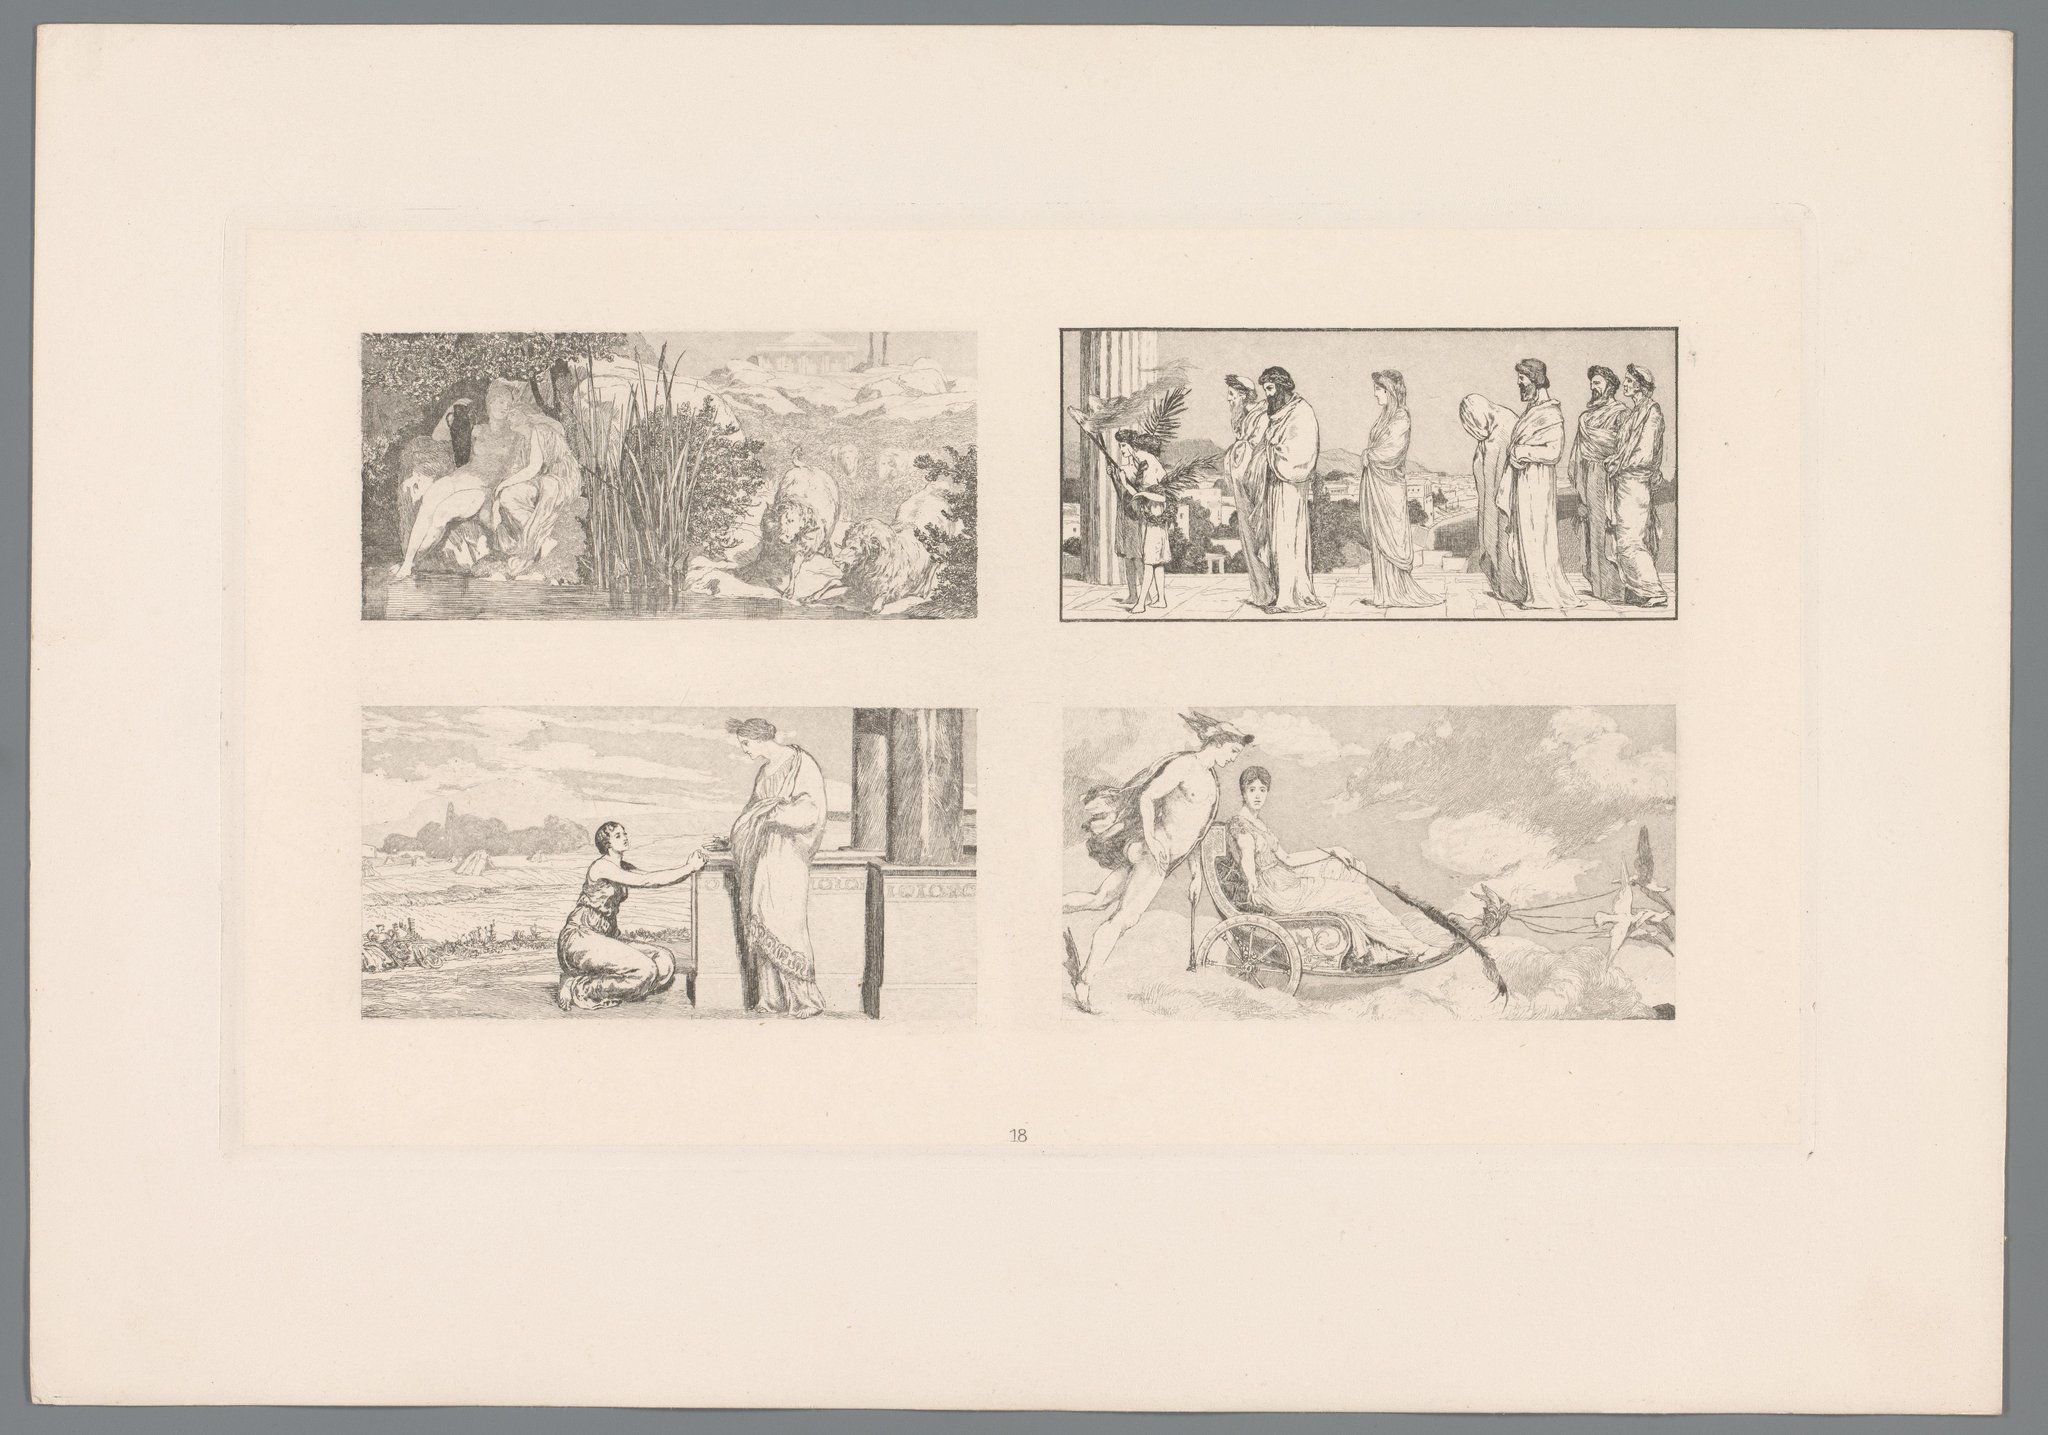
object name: print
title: Hochzeitszug der Psyche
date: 1880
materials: paper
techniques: aquatint, etching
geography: nuremberg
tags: other scenes from the story of cupid and psyche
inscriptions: collector's mark: Lugt 2228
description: Vier afbeeldingen op een prent: Psyche zittend bij een rietkraag, de trouwstoet van Psyche, Psyche knielt voor Ceres, en Venus en Mercurius op een door vogels getrokken wagen.